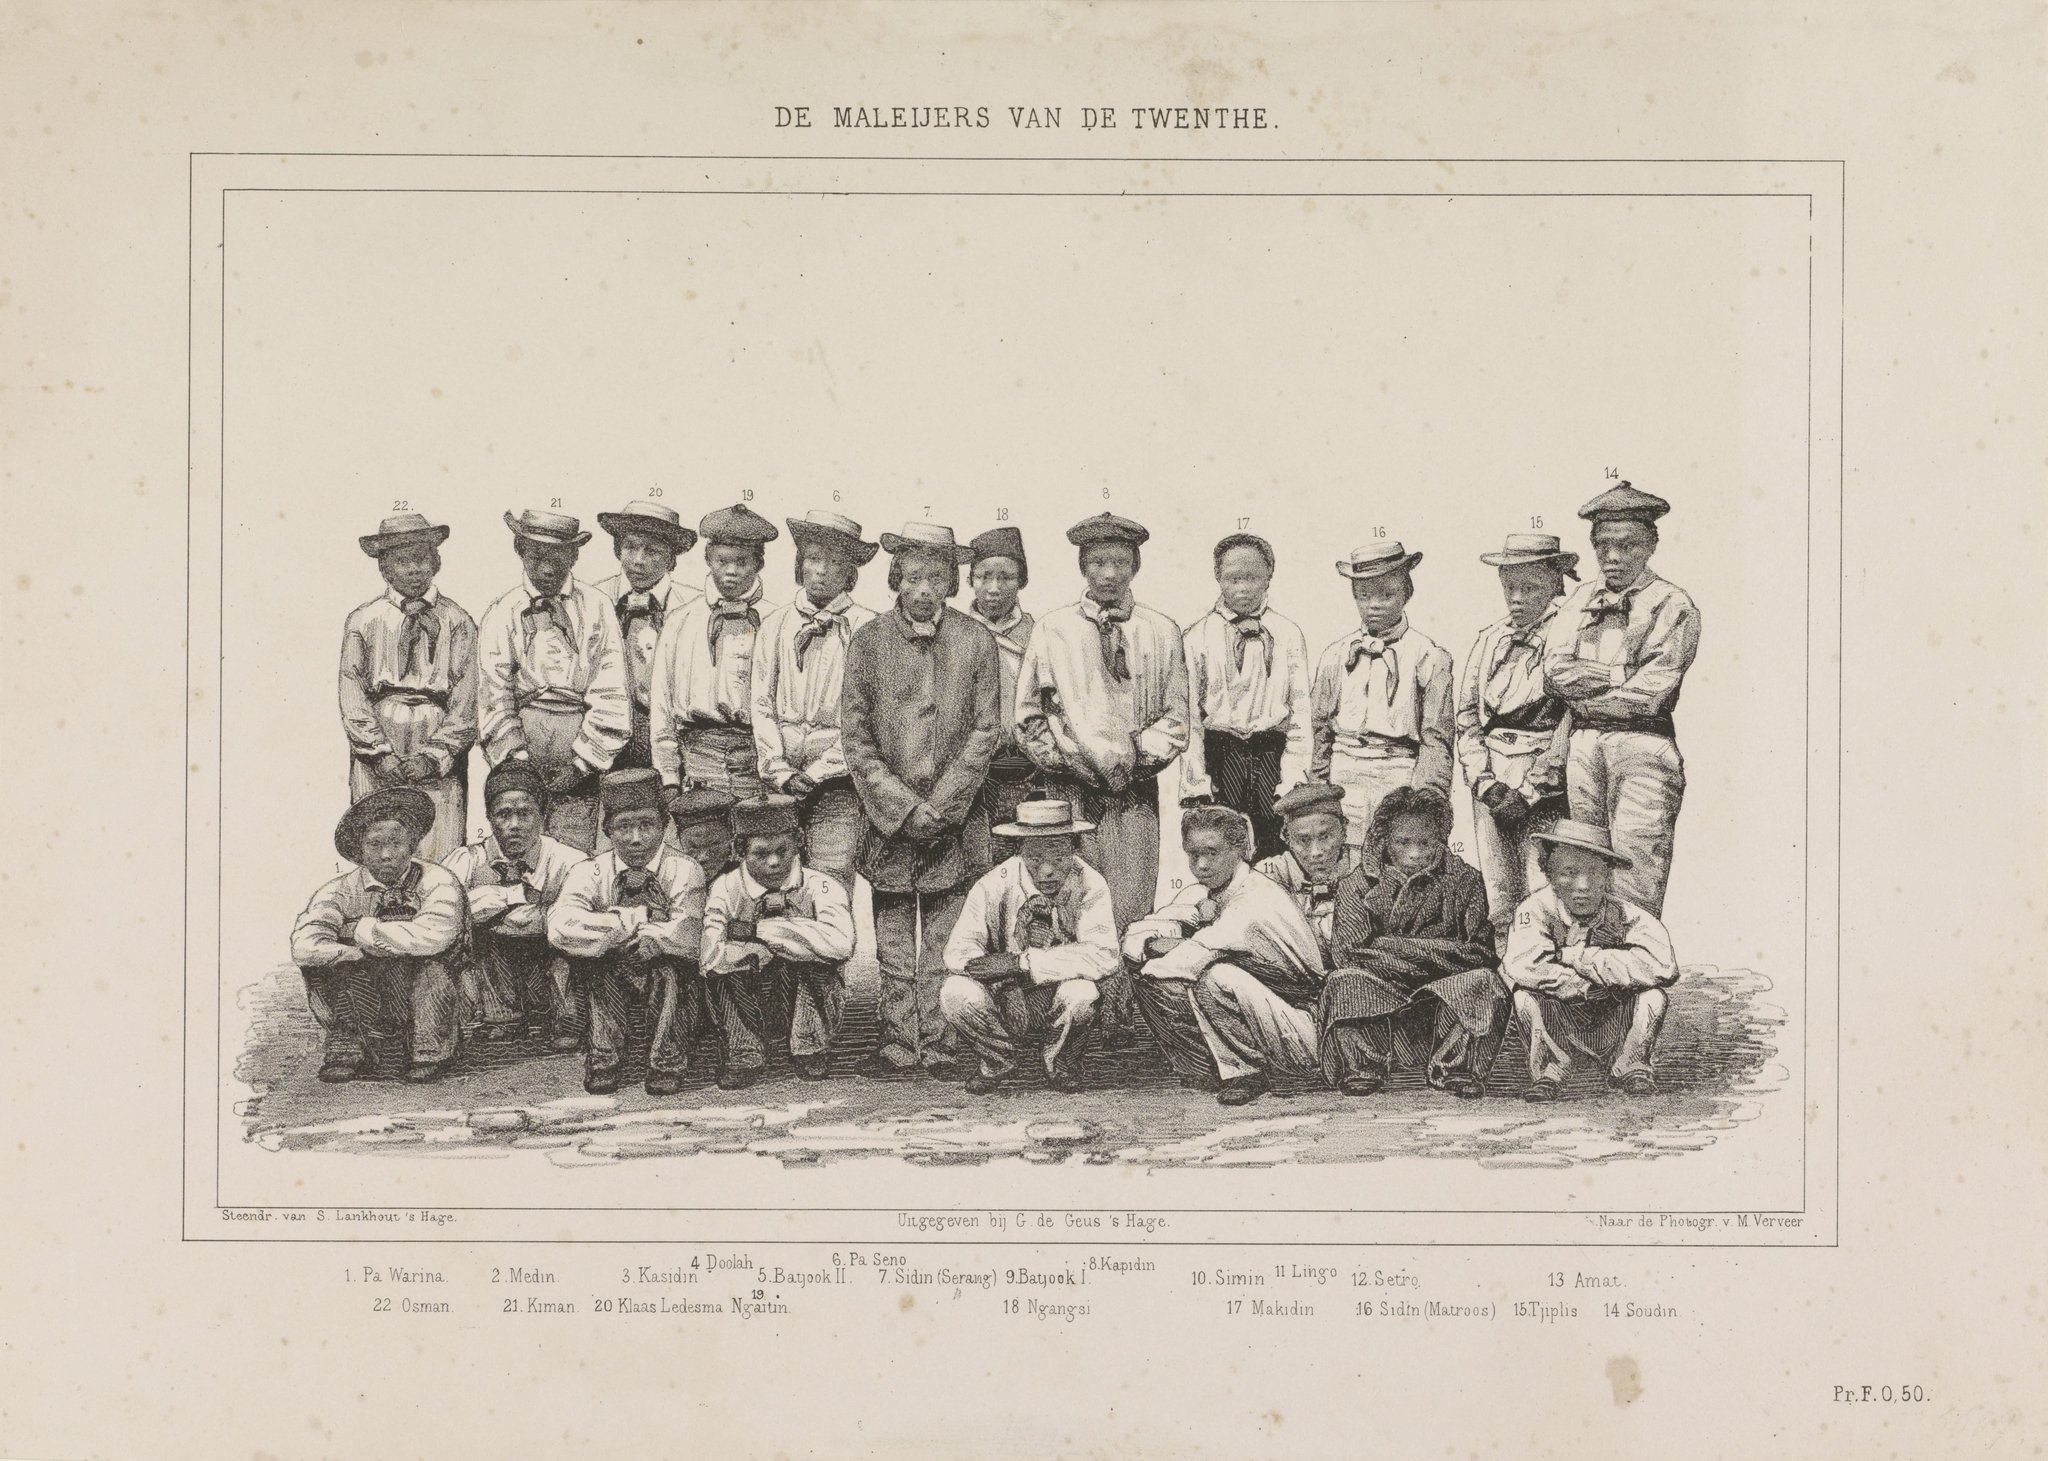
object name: print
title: De Maleiers van het koopvaardijschip 'Twenthe', 1858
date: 1858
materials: paper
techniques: lithograph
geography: the hague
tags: mutiny on ship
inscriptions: collector's mark: Lugt 2228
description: Groepsportret van de 22 Maleiers van het koopvaardijschip 'Twenthe', die op 12 augustus 1856 op weg naar Oost-Indië gemuit hebben en een deel van de bemanning hebben vermoord. Enkelen van hen werden op 1 maart 1858 tot tuchthuisstraf veroordeeld. Onderaan de namen 1-22.